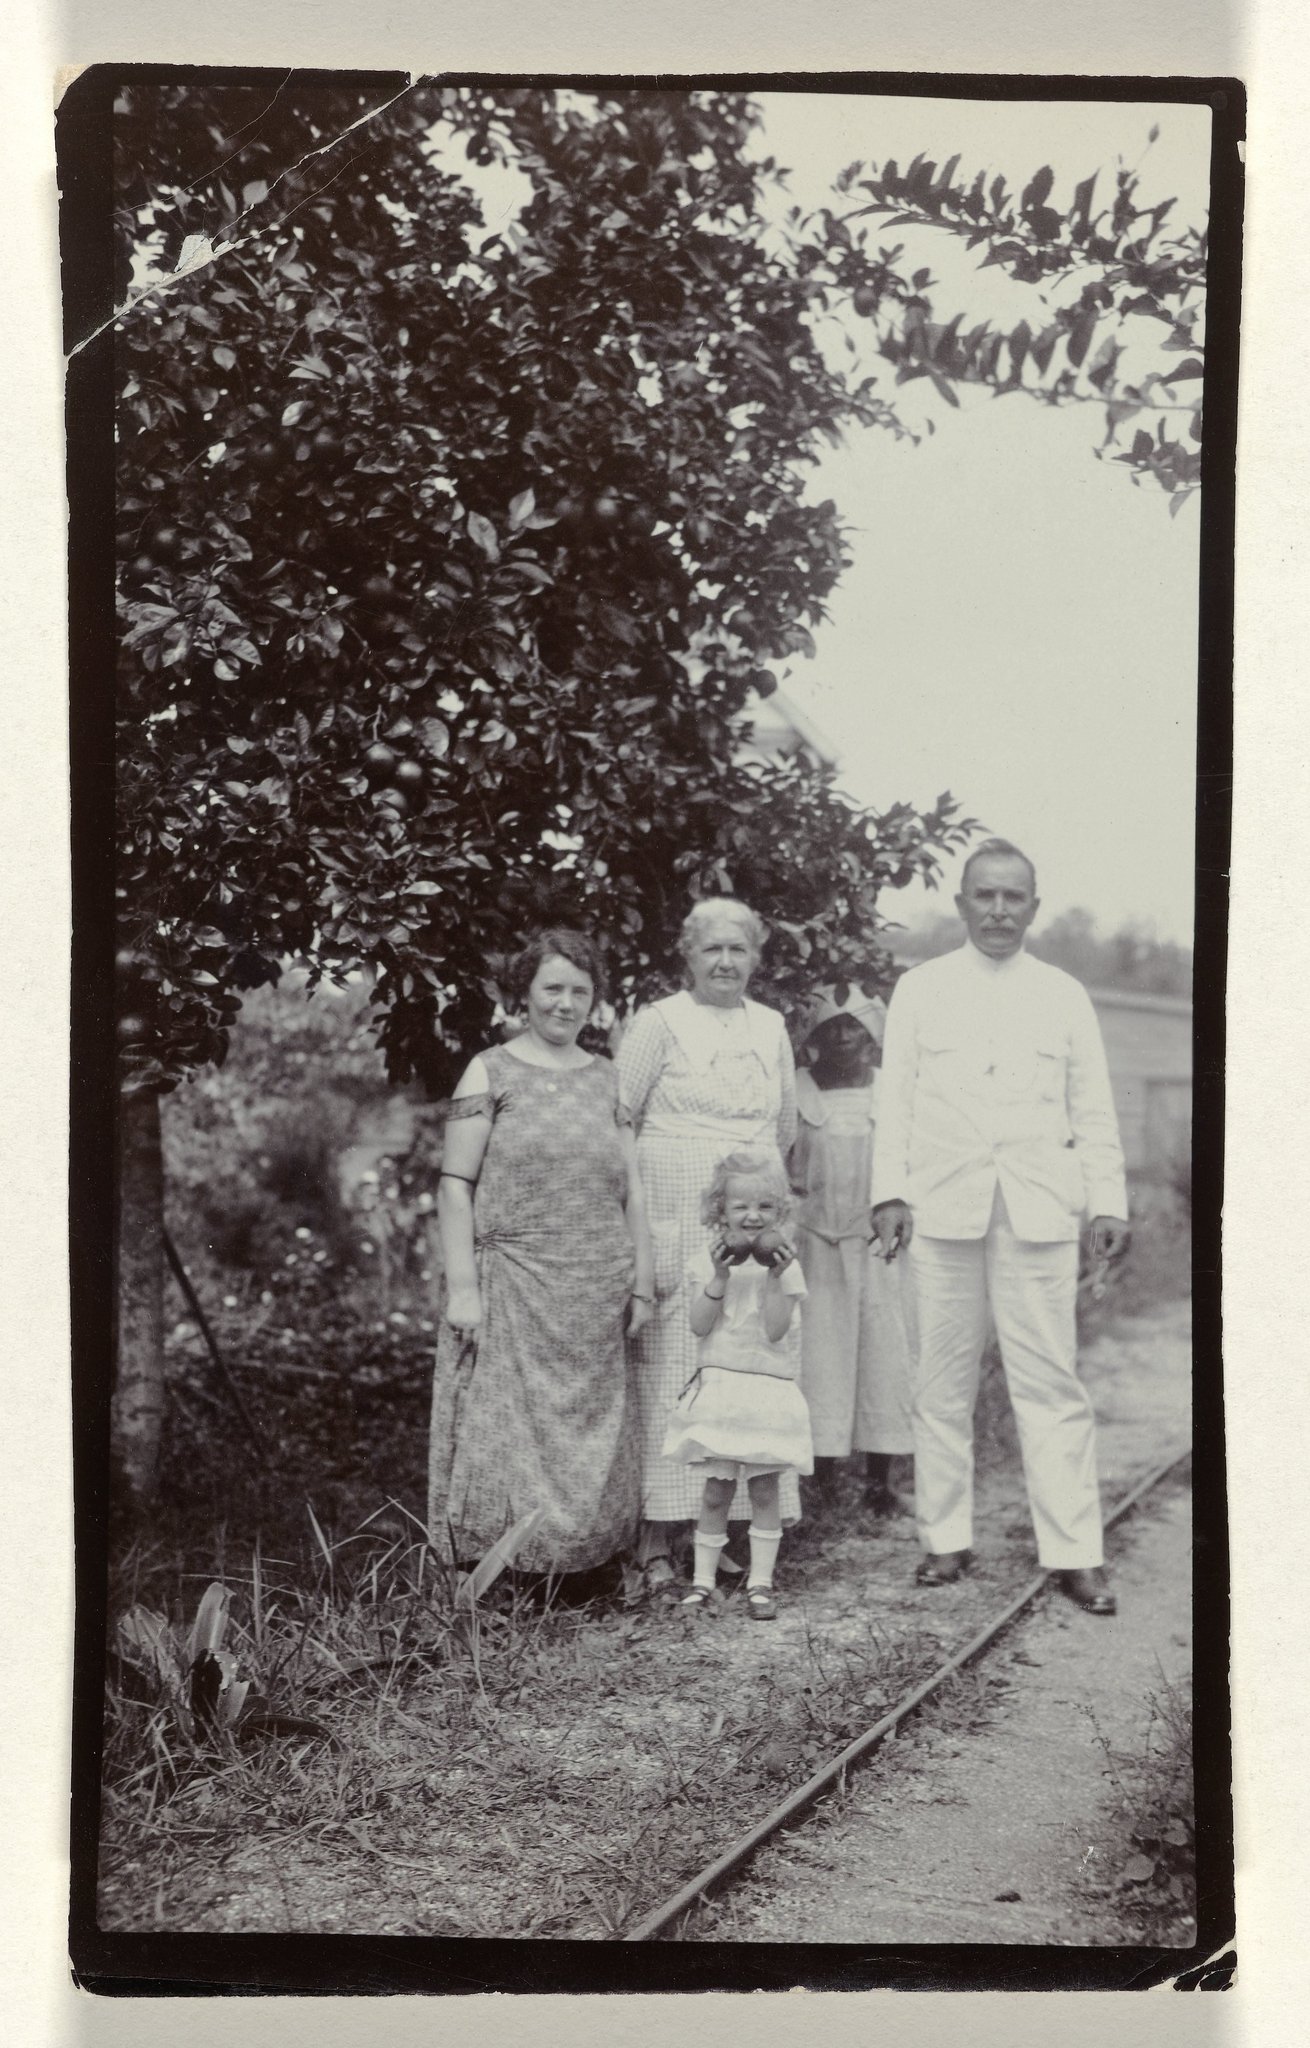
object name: photograph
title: Gezelschap op plantage Clevia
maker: Anonymous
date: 1925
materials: photographic support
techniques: photography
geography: suriname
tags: suriname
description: Gezelschap bestaande uit een Nederlands gezin en een Surinaamse vrouw, staande bij een rails, op plantage Clevia. Onderdeel van een groep foto's van de familie Boom-Gonggrijp in Suriname.